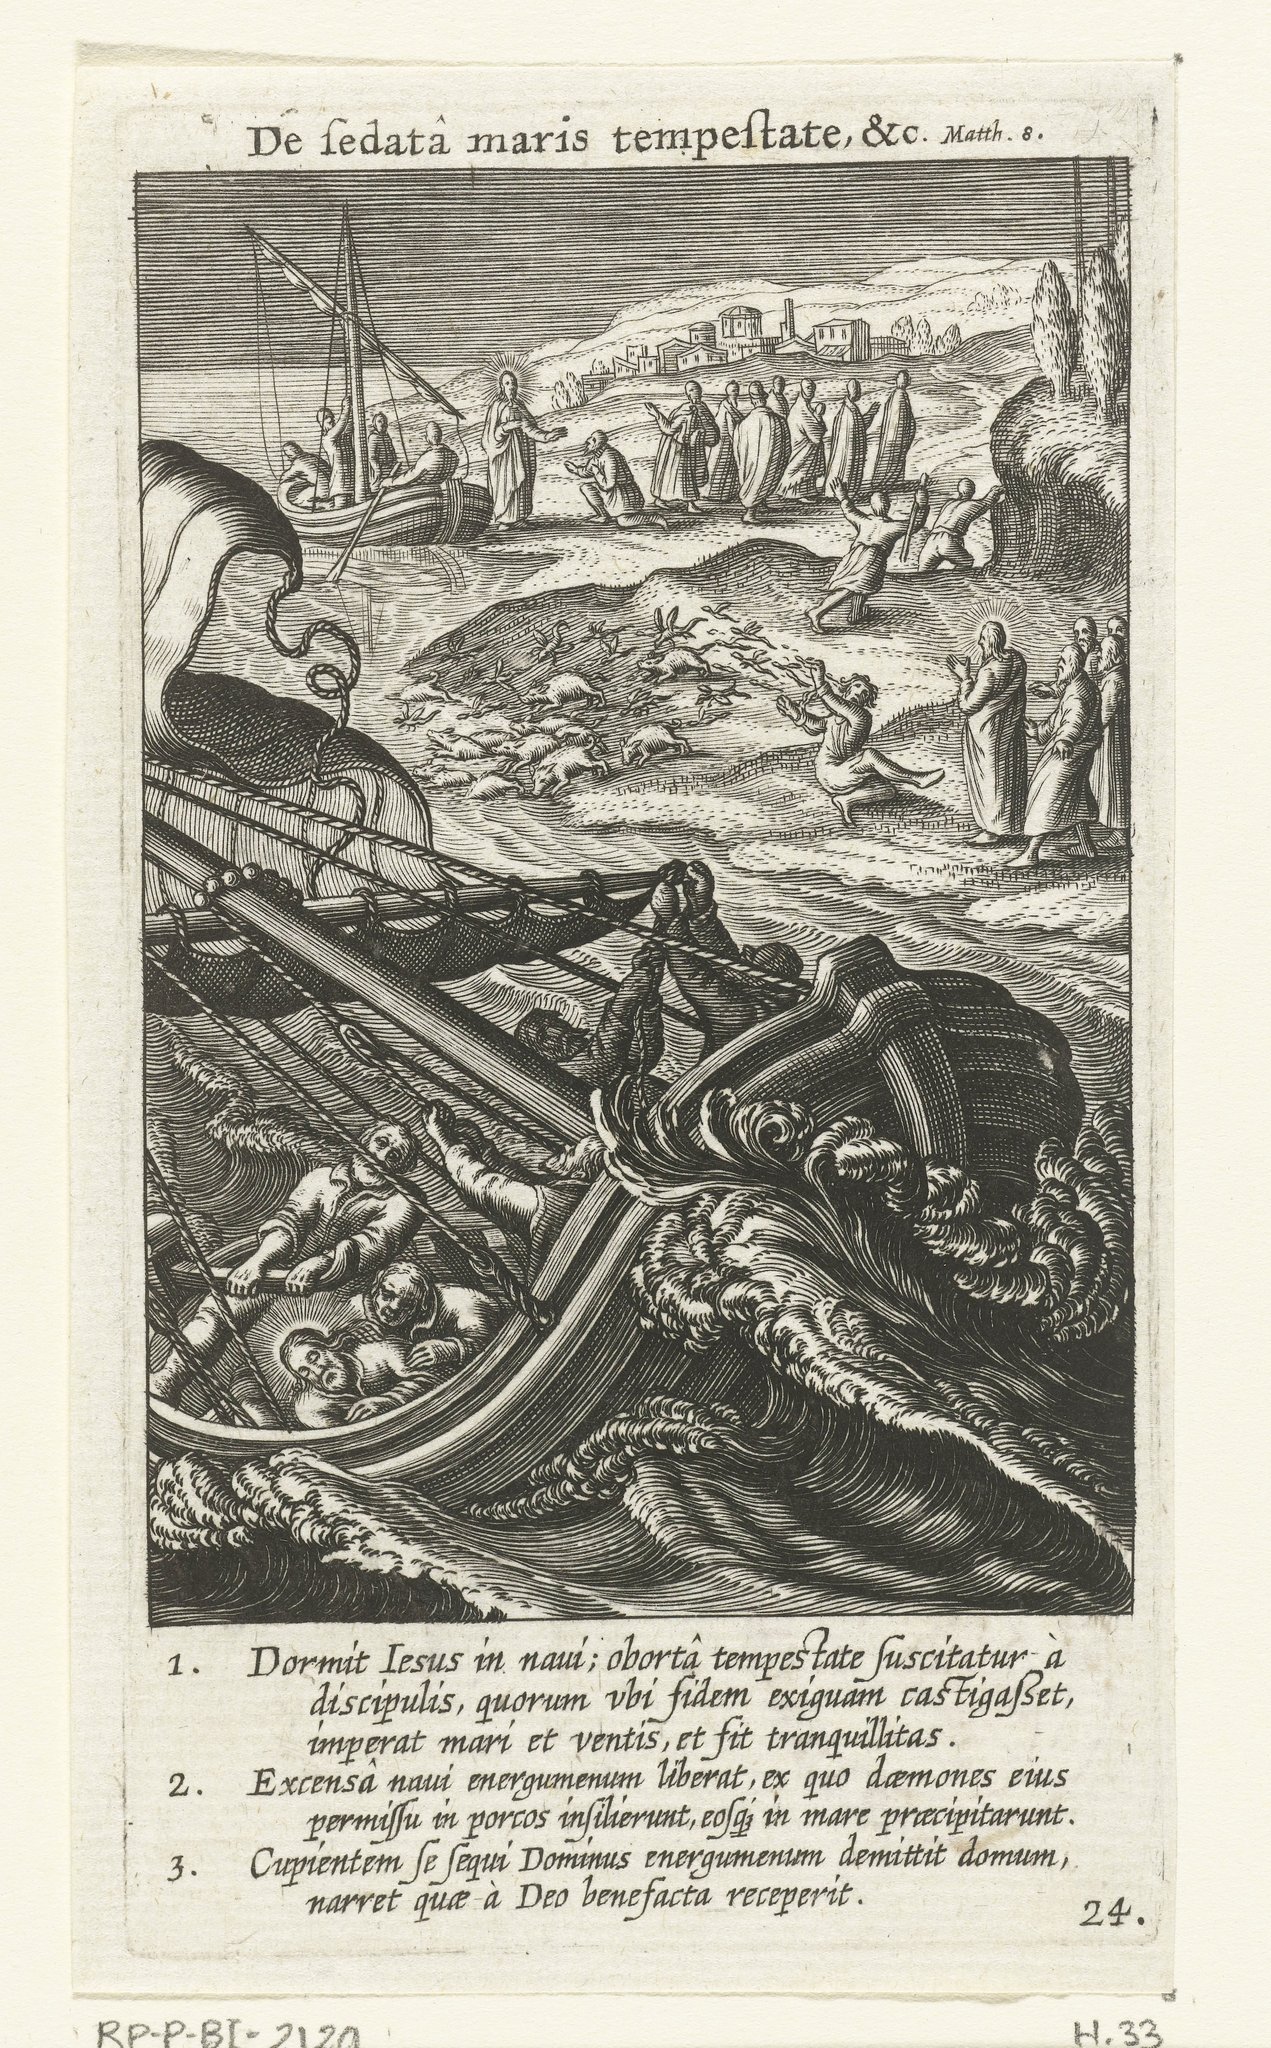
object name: print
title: Vitae passionis et mortis Jesu Christ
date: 1590-1622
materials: paper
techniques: engraving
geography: antwerp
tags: story of christ stilling the storm on the sea of galilee (matthew 8:23-27; mark 4:35-41; luke 8:22-25)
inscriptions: collector's mark: Lugt 240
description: Prent uit: Joannes Bourgois, Vitae passionis et mortis Jesu Christi Somini nostri mysteria, Antwerpen Hendrick Aertssens, 1622, afb. 24